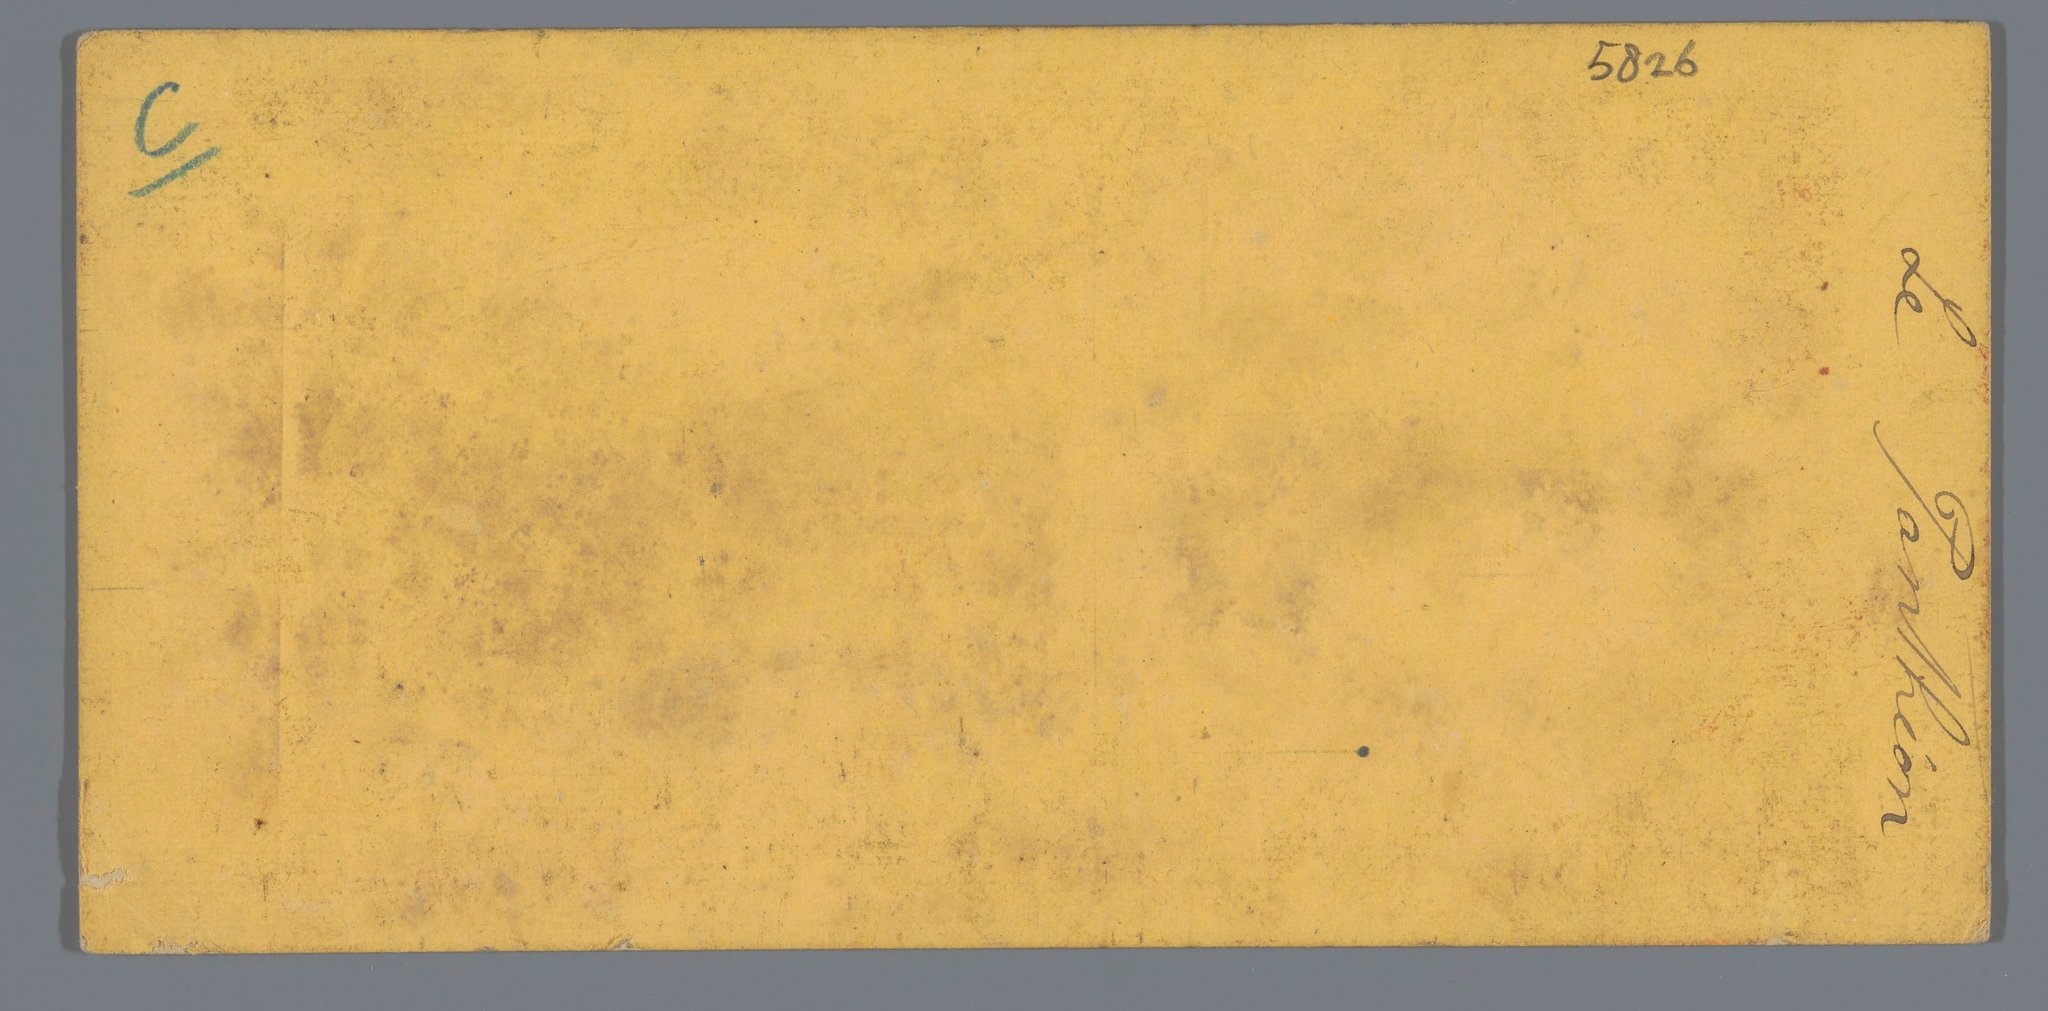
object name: stereograph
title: Gezicht op het Panthéon in Parijs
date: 1850-1880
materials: cardboard, photographic support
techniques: albumen print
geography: paris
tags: dome ~ architecture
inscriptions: inscription: ‘Le Panthéon’